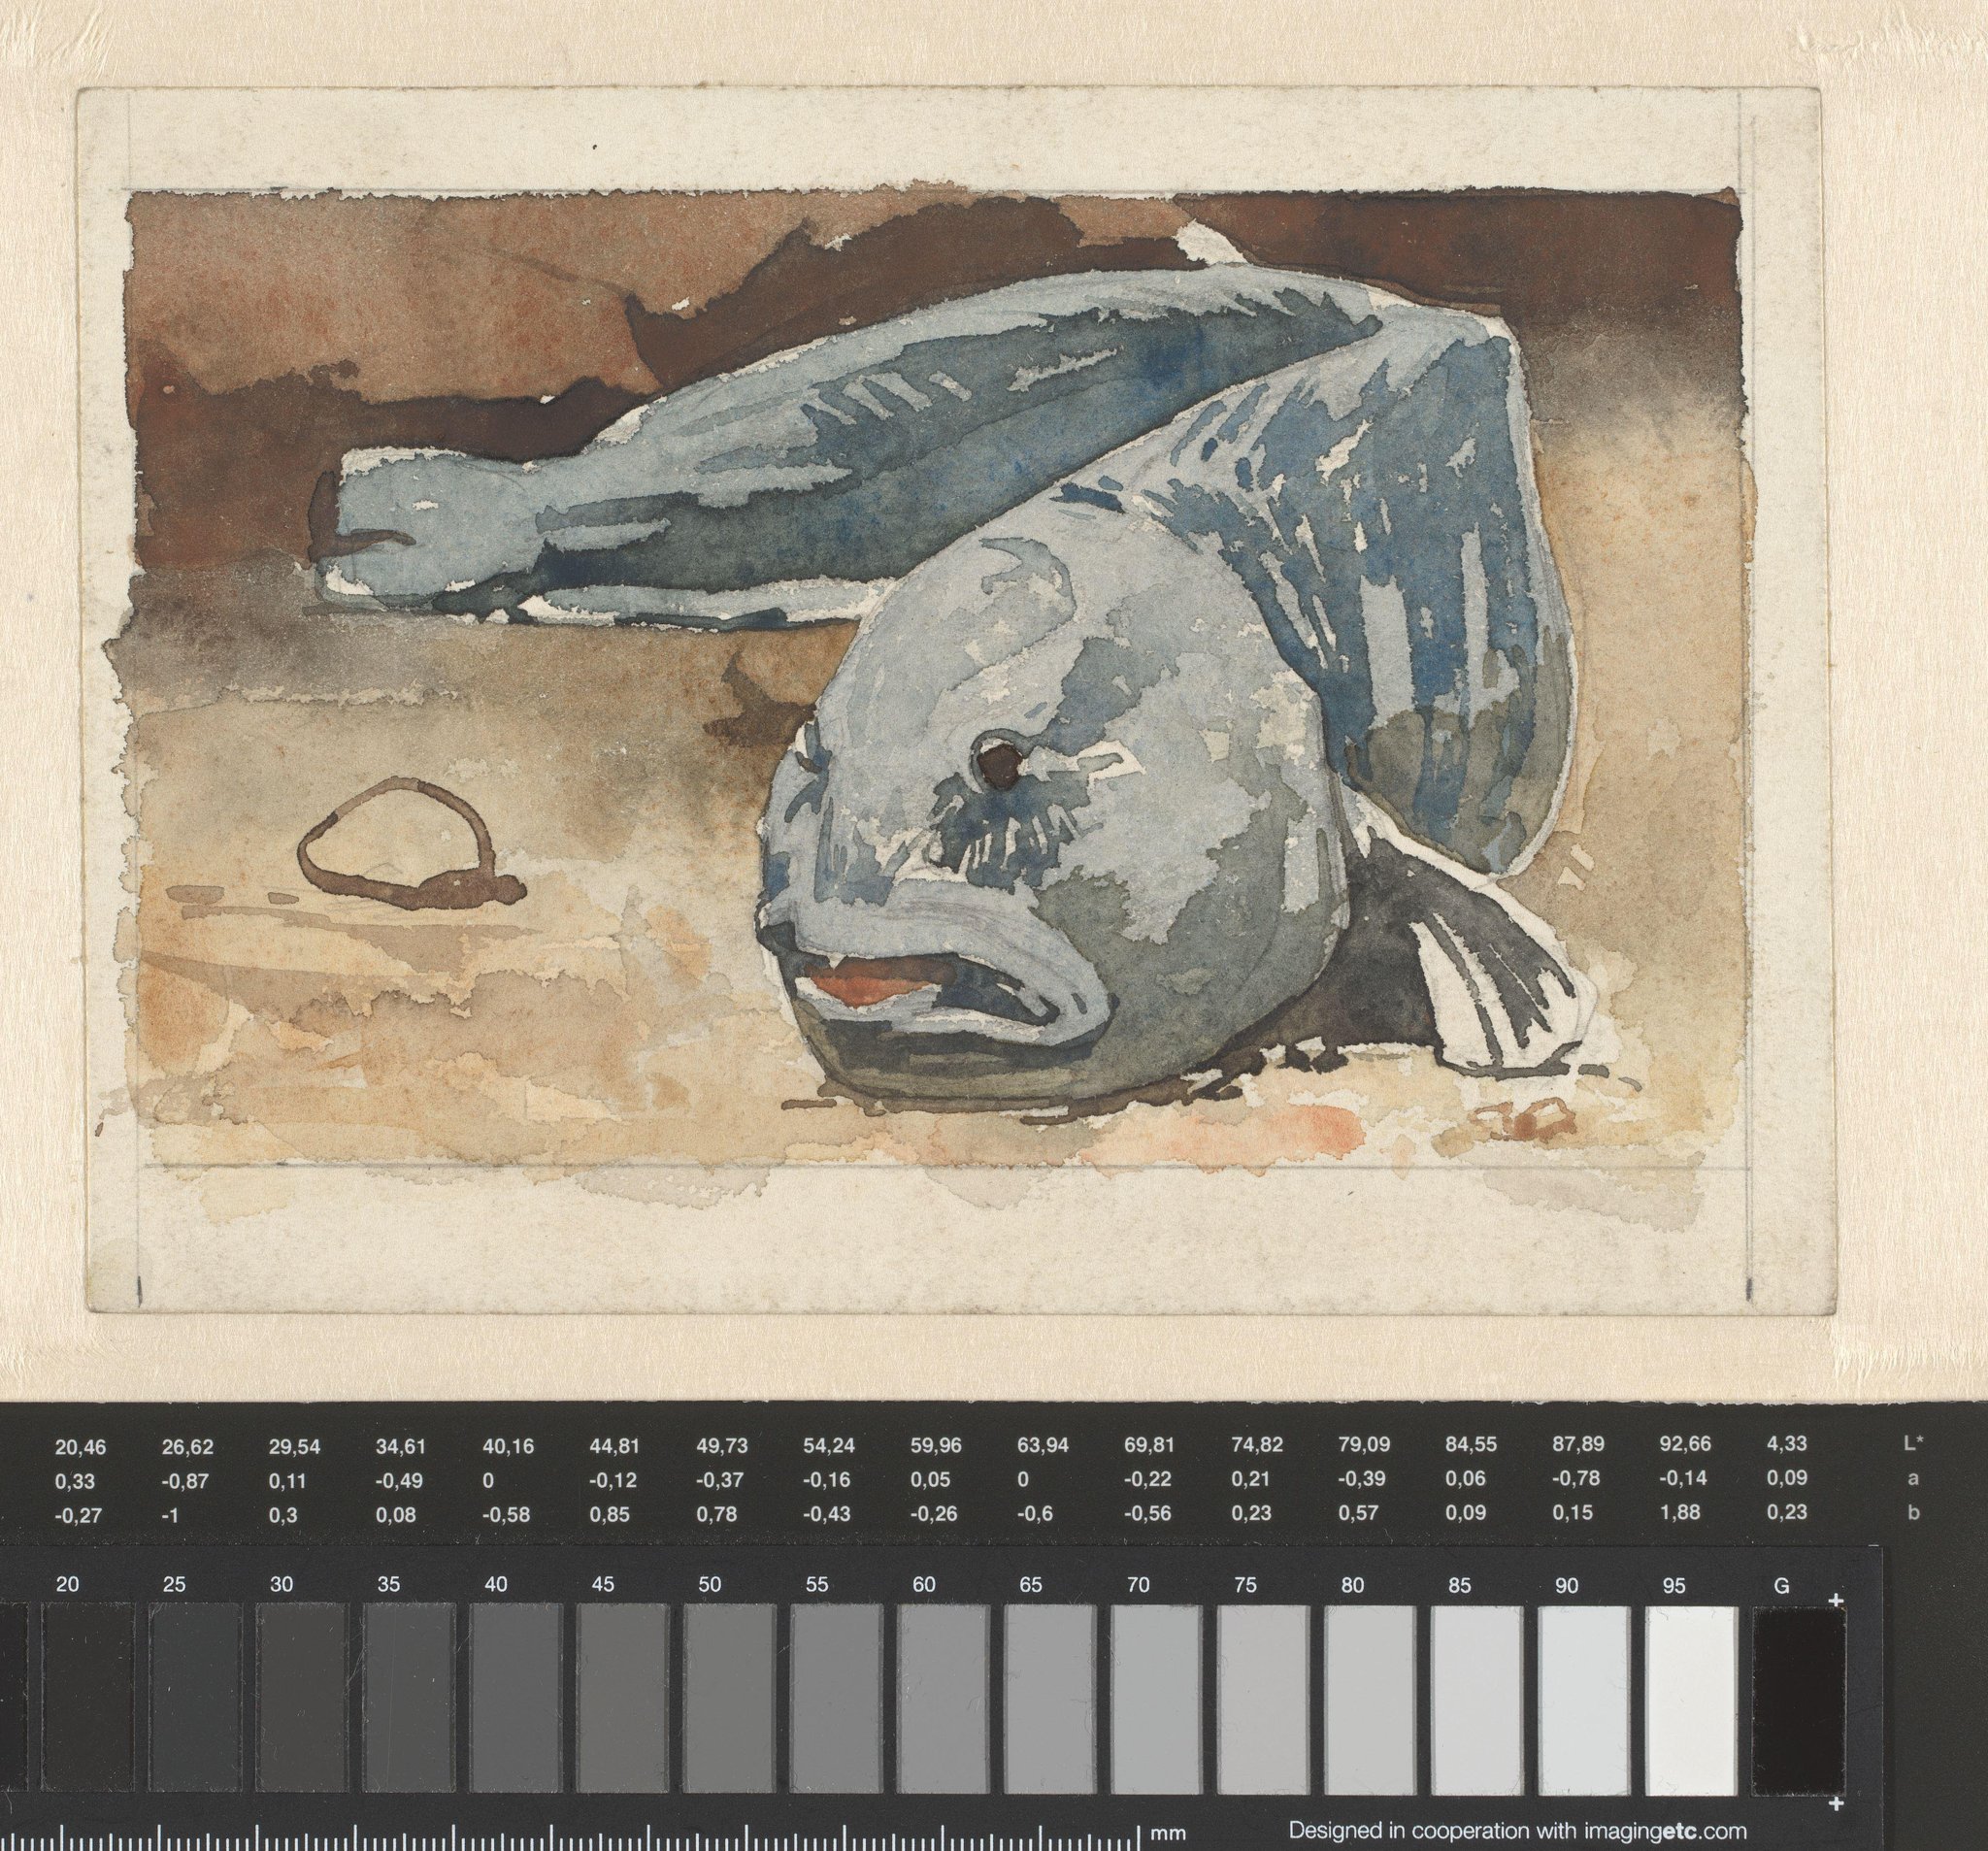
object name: drawing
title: Vis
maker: willem witsen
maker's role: draughtsman, painter, print maker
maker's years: 1860-1923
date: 1870-1923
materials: paper, pencil, watercolor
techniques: brush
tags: bony fishes